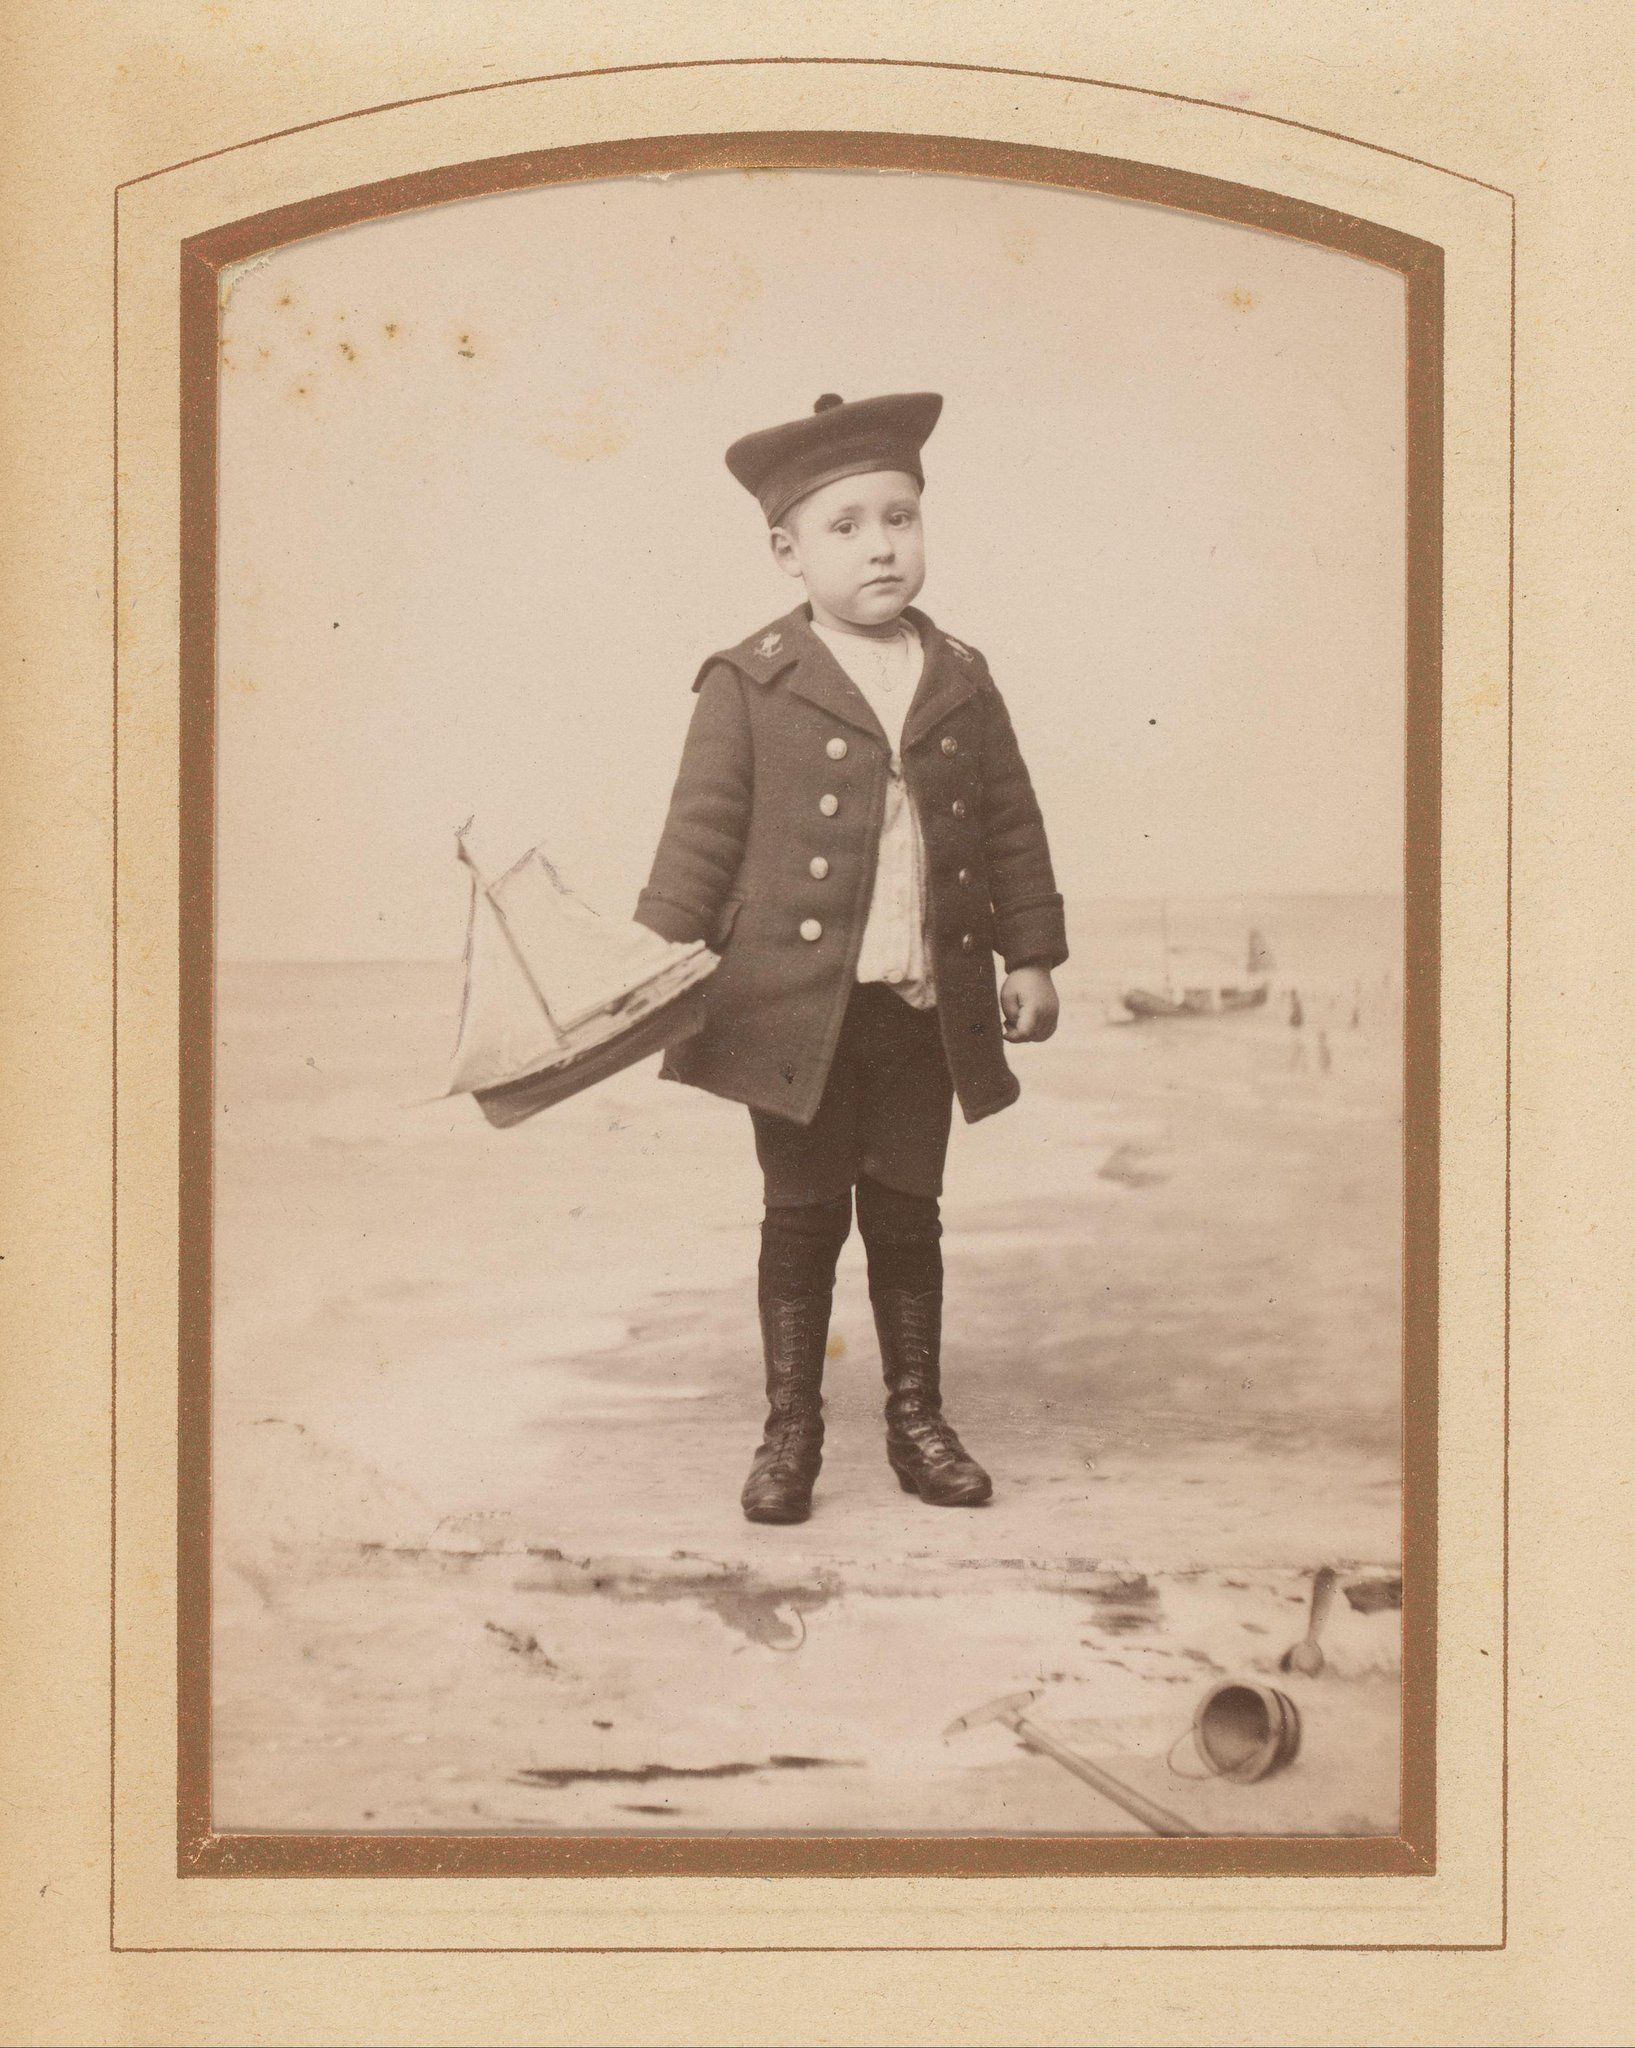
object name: cabinet photograph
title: Portret van een jongen met speelgoed boot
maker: hendrik jonker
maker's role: fotograaf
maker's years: 1846-1932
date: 1882-1914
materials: cardboard, photographic support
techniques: collodion silver print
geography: leiden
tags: ensemble of pieces of clothing: sailor suit, boy (child between toddler and youth)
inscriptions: inscription: ‘H. Jonker/ Apothekersdijk No 7/ Leiden’, annotation: ‘AV’